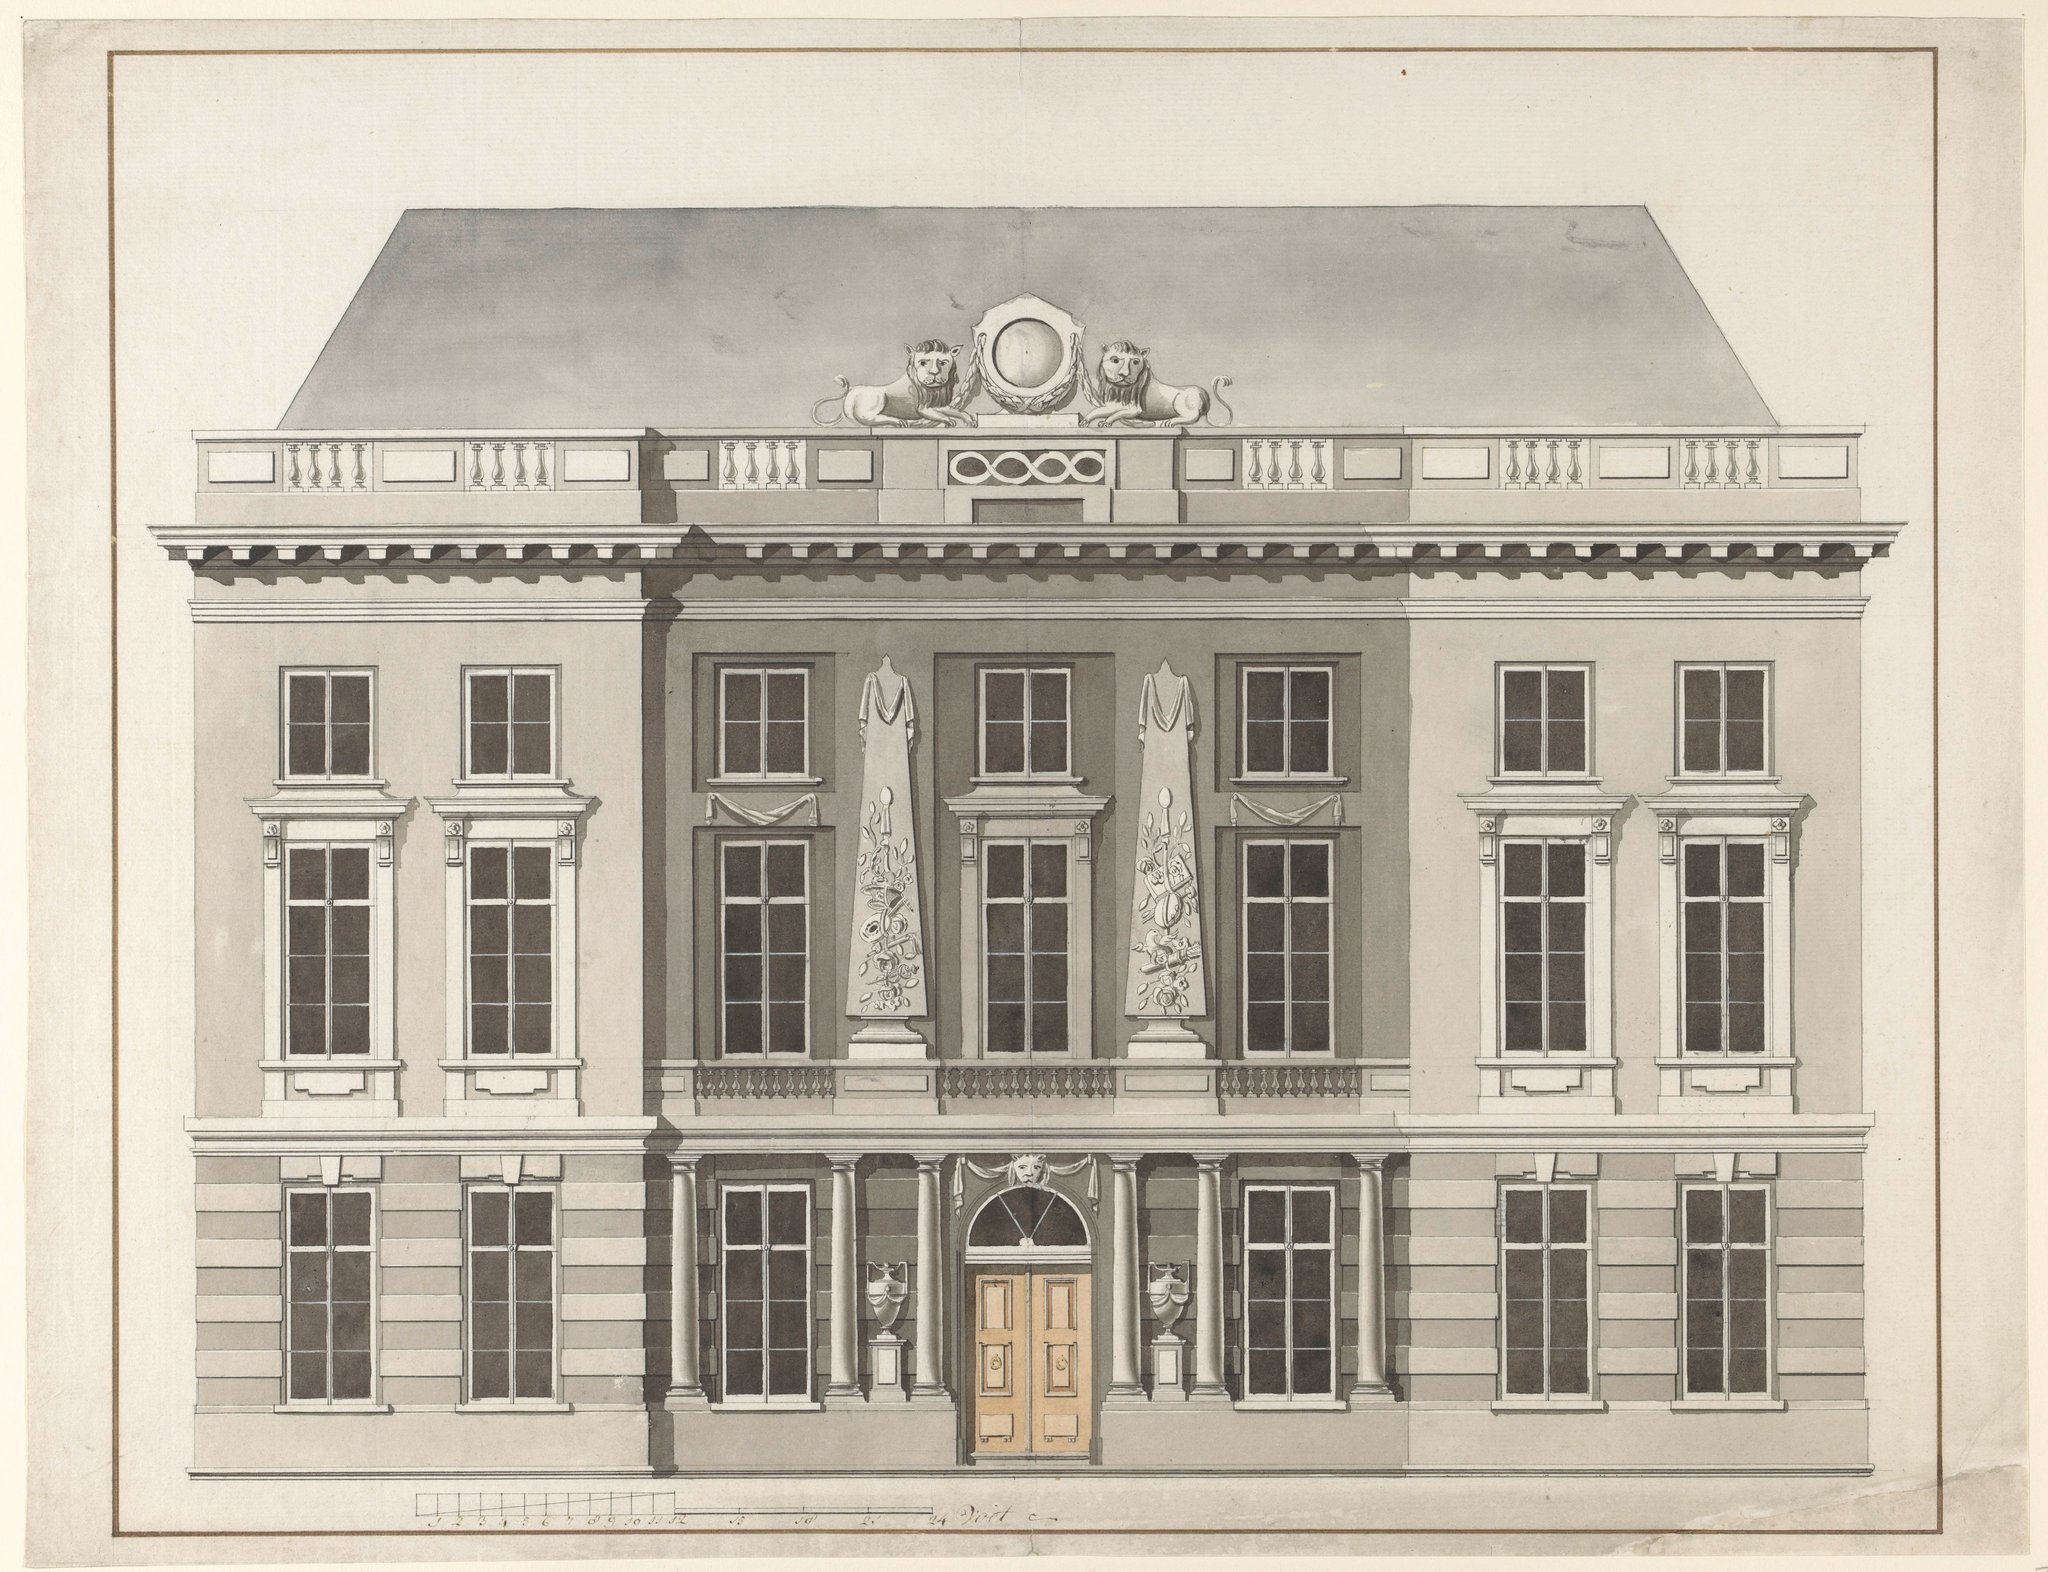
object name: drawing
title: Ontwerp voor een classicistische gevel met beeldhouwwerk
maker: c. taselaar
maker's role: draughtsman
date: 1775-1799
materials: ink, paper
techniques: brush, pen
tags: façade (of house or building), civic architecture; edifices; dwellings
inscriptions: inscription: ‘(...)’